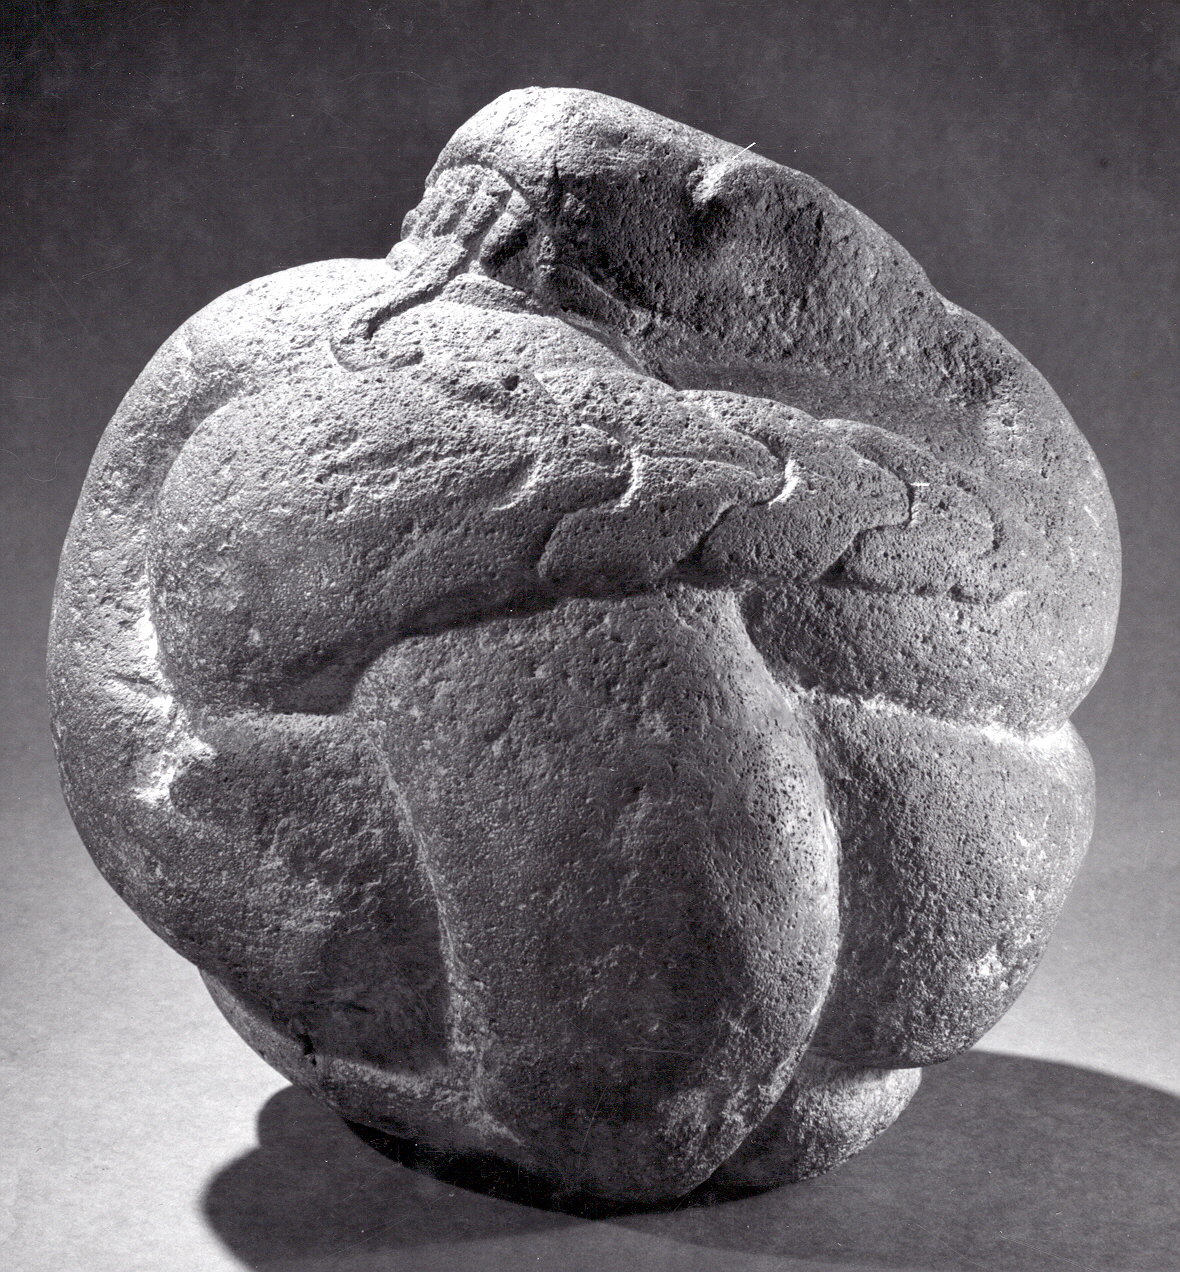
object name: snake figure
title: Coiled Serpent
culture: mexica, aztec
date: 1401-1600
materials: pigment, stone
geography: mexico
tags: serpents